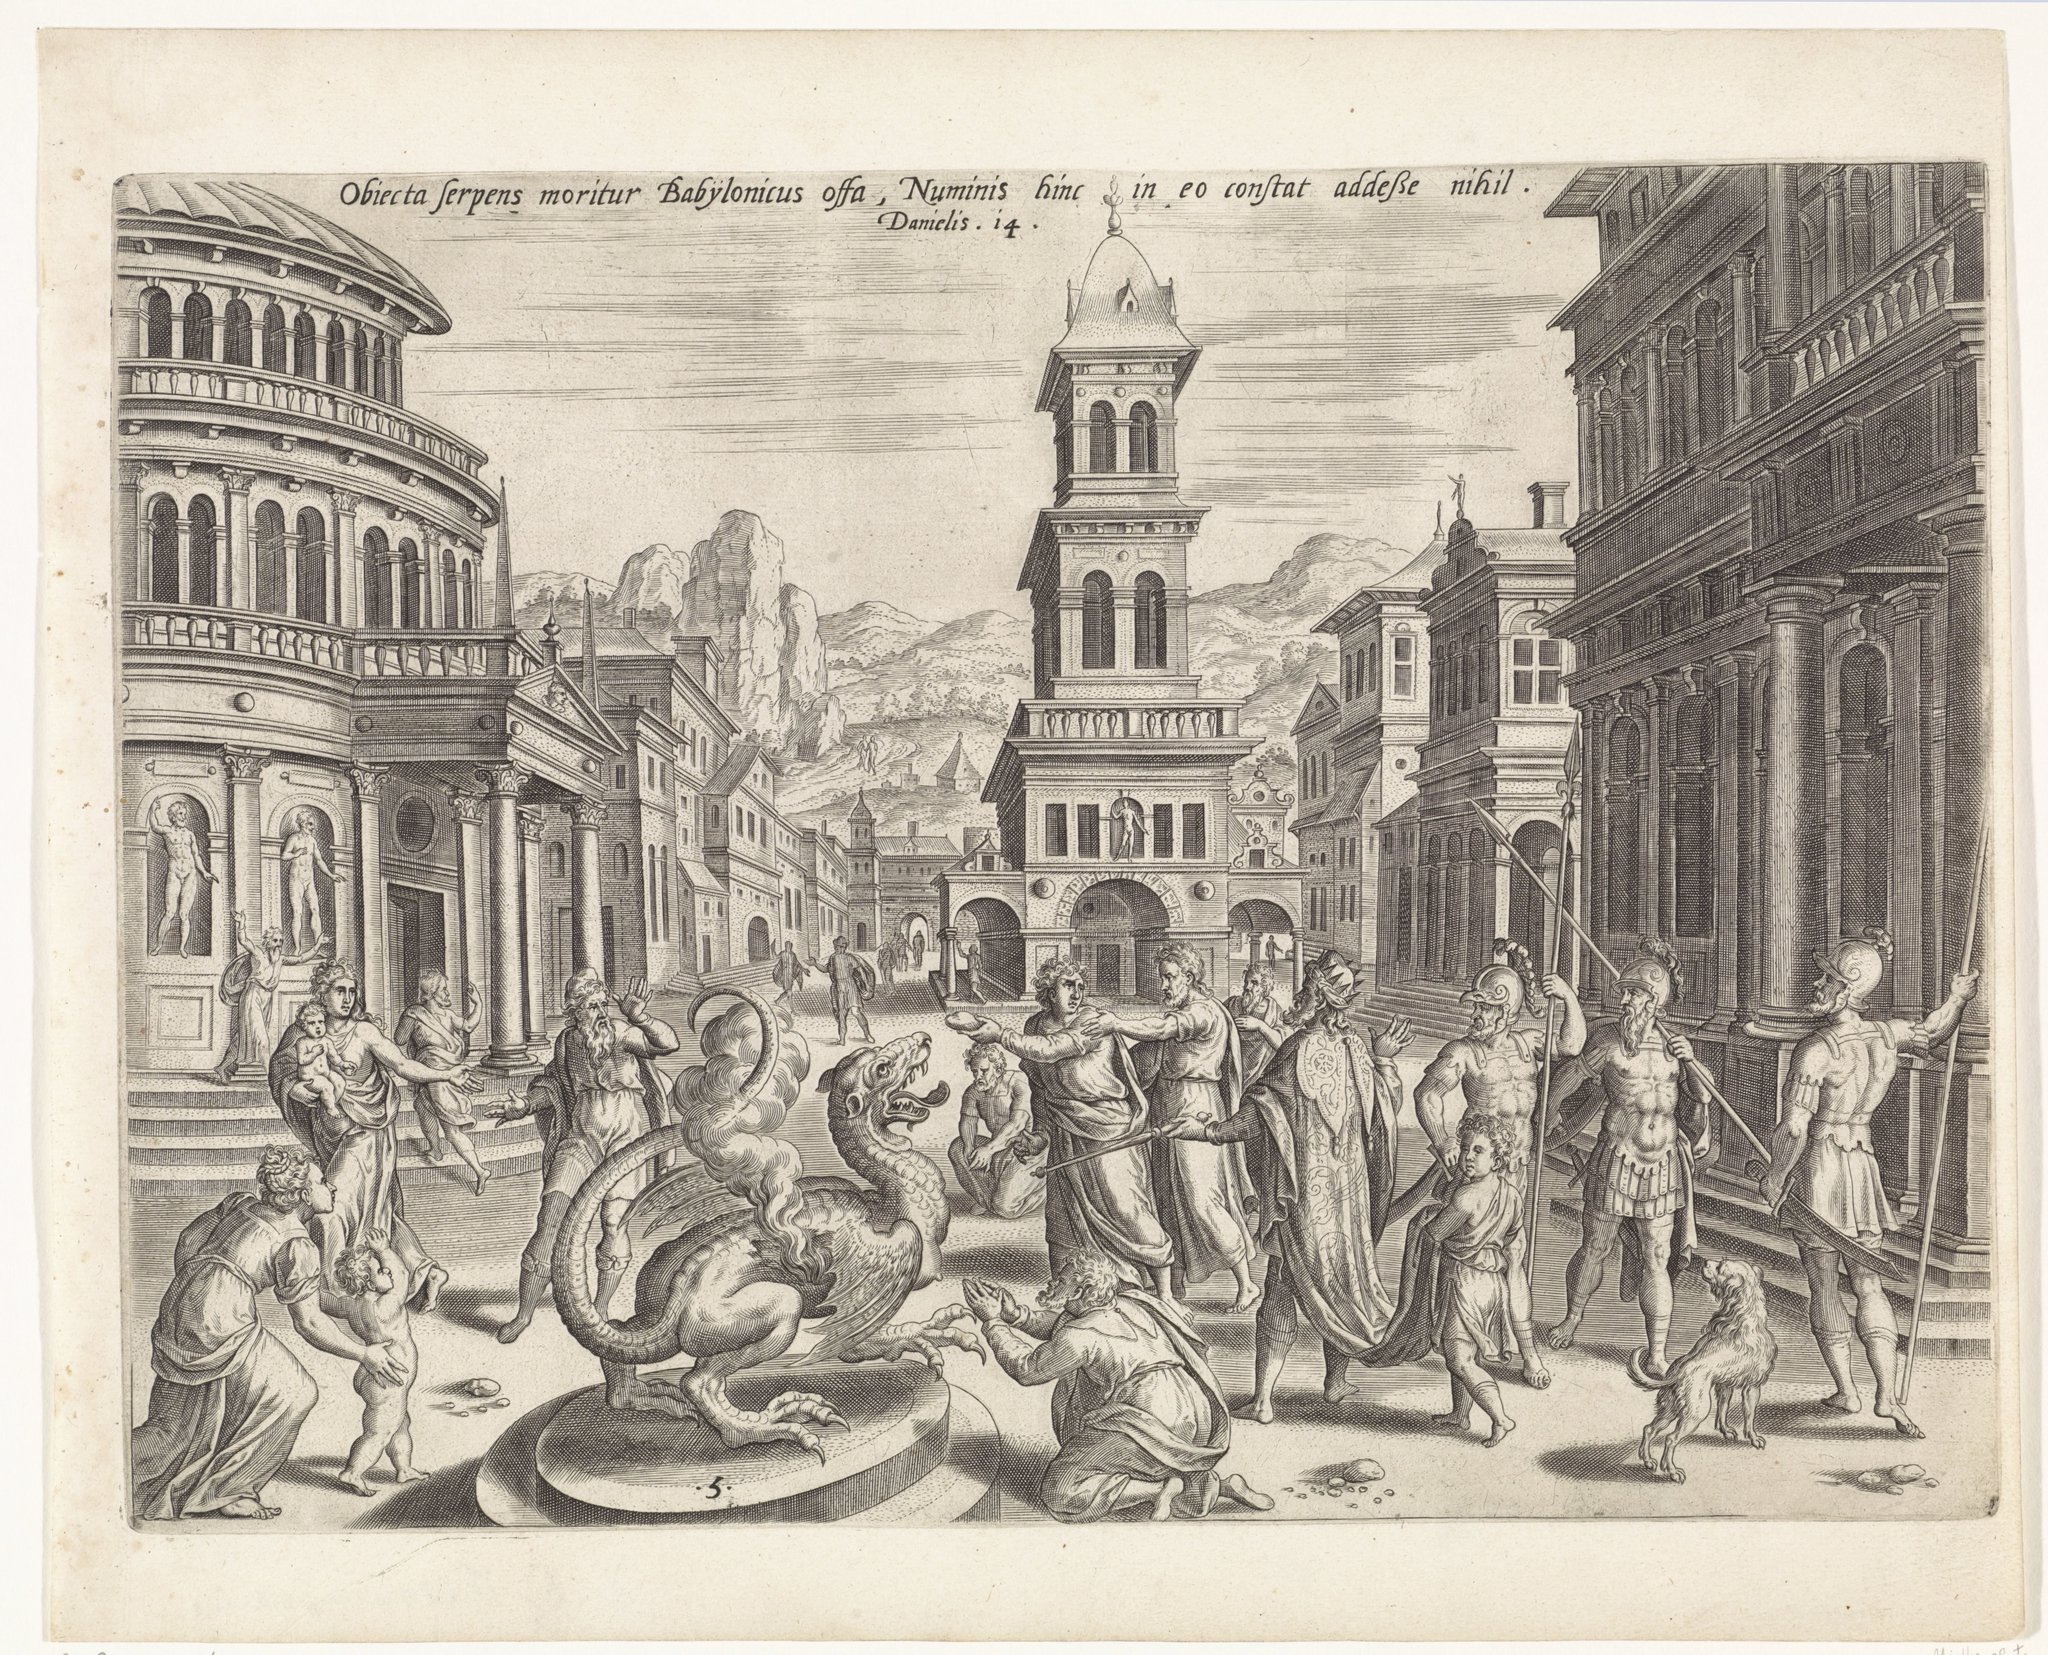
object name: print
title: Thesaurus sacrarum historiarum veteris testamenti (...)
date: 1579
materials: paper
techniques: etching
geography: antwerp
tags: daniel gives food to the dragon; king cyrus looking on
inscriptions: collector's mark: Lugt 2228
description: Prent gebruikt in: Thesaurus sacrarum historiaru veteris testamenti, elegatissimis imaginibus expressu excelletissimoru in hac arte viroru opera : nuc primu in luce editus. Antwerpen: Gerard de Jode, 1579. Of prent gebuikt in: Thesaurus sacrarum historiaru[m] veteris (et novi) testame[n]ti, elega[n]tissimis imaginibus expressu[m] excelle[n]tissimoru[m] in hac arte viroru[m] opera : nu[n]c primu[m] in luce[m] editus. Antwerpen: Gerard de Jode, 1585.